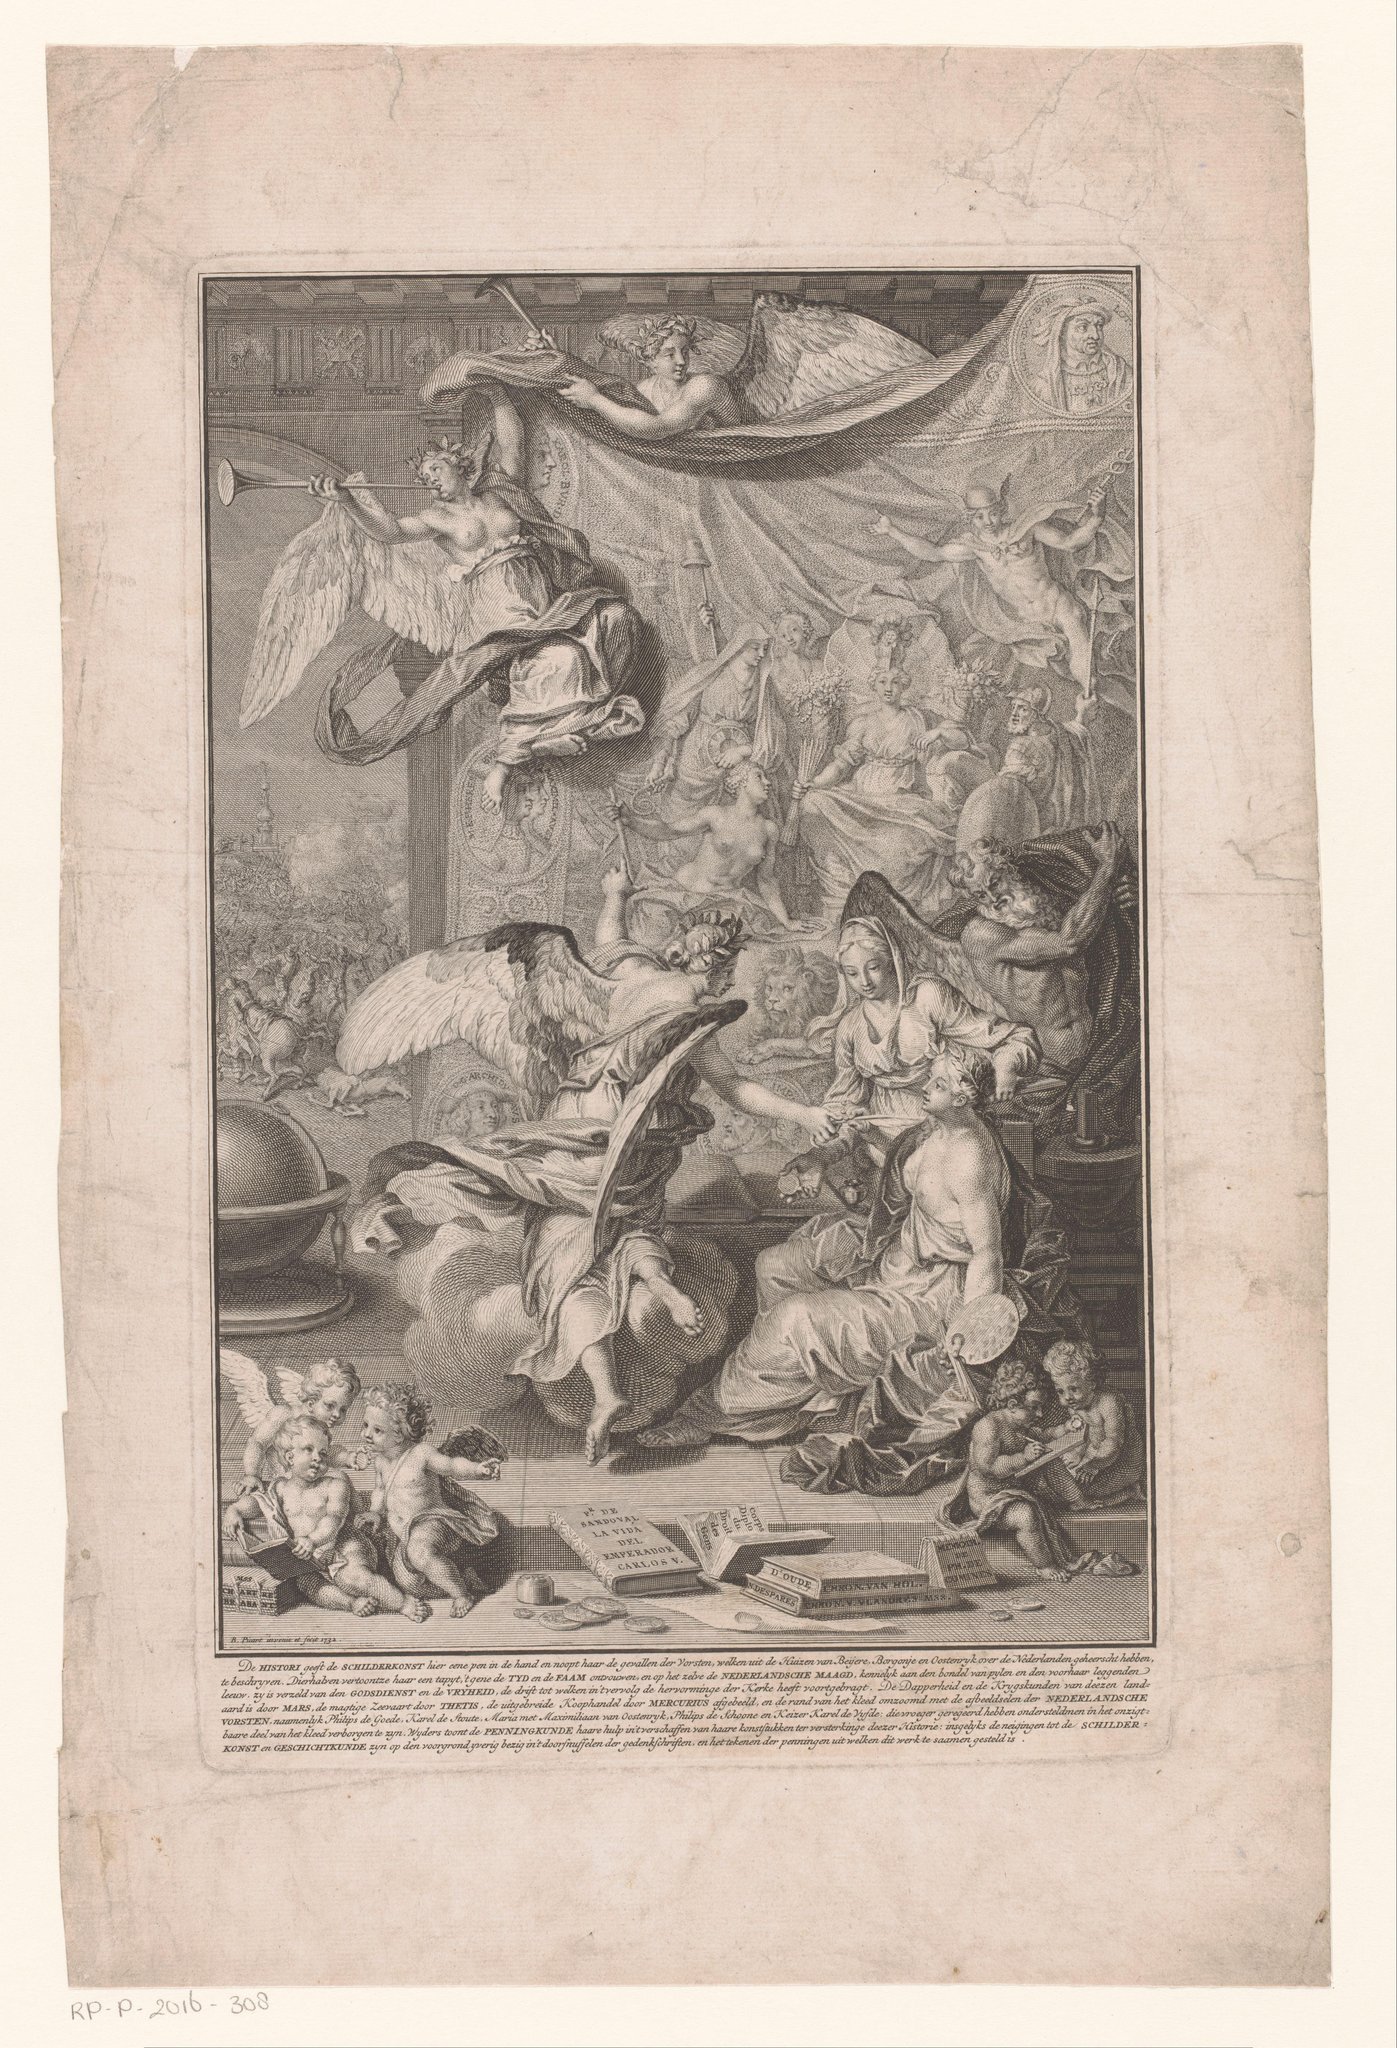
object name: titelblad, titelpagina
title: Geschiedenis geeft de Schilderkunst een schrijfveer om de geschiedenissen van de Nederlandse vorsten op te tekenen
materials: paper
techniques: engraving, etching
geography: the hague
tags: 'pictura', symbolic representations, allegories and emblems ~ painting; 'pittura' (ripa), personifications of countries, nations, states, districts, etc., 'historia'; 'historia' (ripa)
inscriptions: collector's mark: Lugt 2228, collector's mark: Lugt 2760, inscription: ‘28-11-85 / 1 + 2’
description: Allegorische voorstelling waarin Geschiedenis de Schilderkunst een schrijfveer in de hand geeft om de geschiedenissen van de Nederlandse vorsten op te tekenen. Ze wijst op een tapijt waarop de Nederlandse Maagd, vergezeld door Vrijheid, Geloof, Thetis, Mars en Mercurius en langs de randen medaillons waarin de portretten van Nederlandse vorsten. Links op de achtergrond een veldslag. Met een zevenregelig onderschrift in het Nederlands.